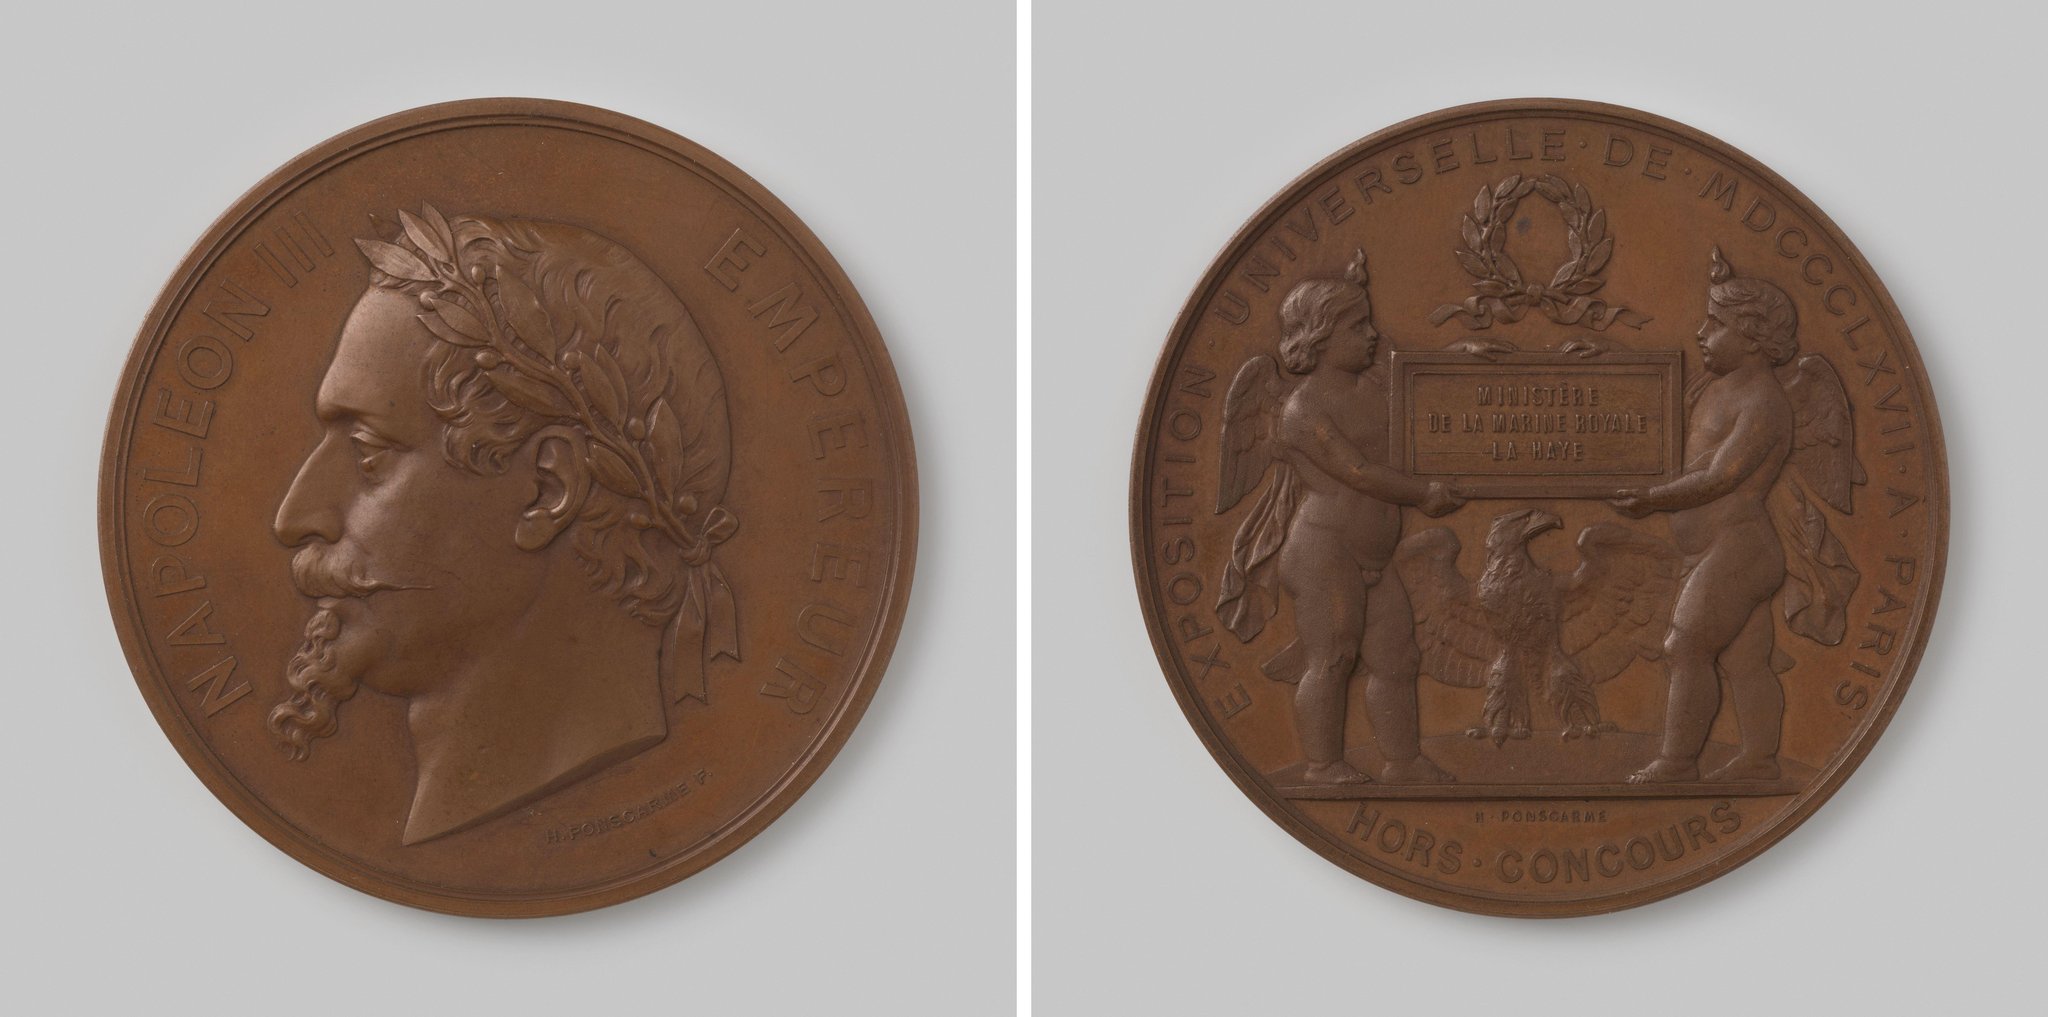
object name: history medal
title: Wereldtentoonstelling te Parijs 1867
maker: hubert ponscarme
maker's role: medailleur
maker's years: 1827-1903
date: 1867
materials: bronze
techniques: striking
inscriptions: hallmark: ‘(rozet) CUIVRE’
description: Bronzen penning, de voorzijde het portret van Keizer Napoleon III naar links met omschrift, op de keerzijde twee genien met een tablet waarboven een krans, op de achtergrond een adelaar, met omschrift en afsnedetekst.